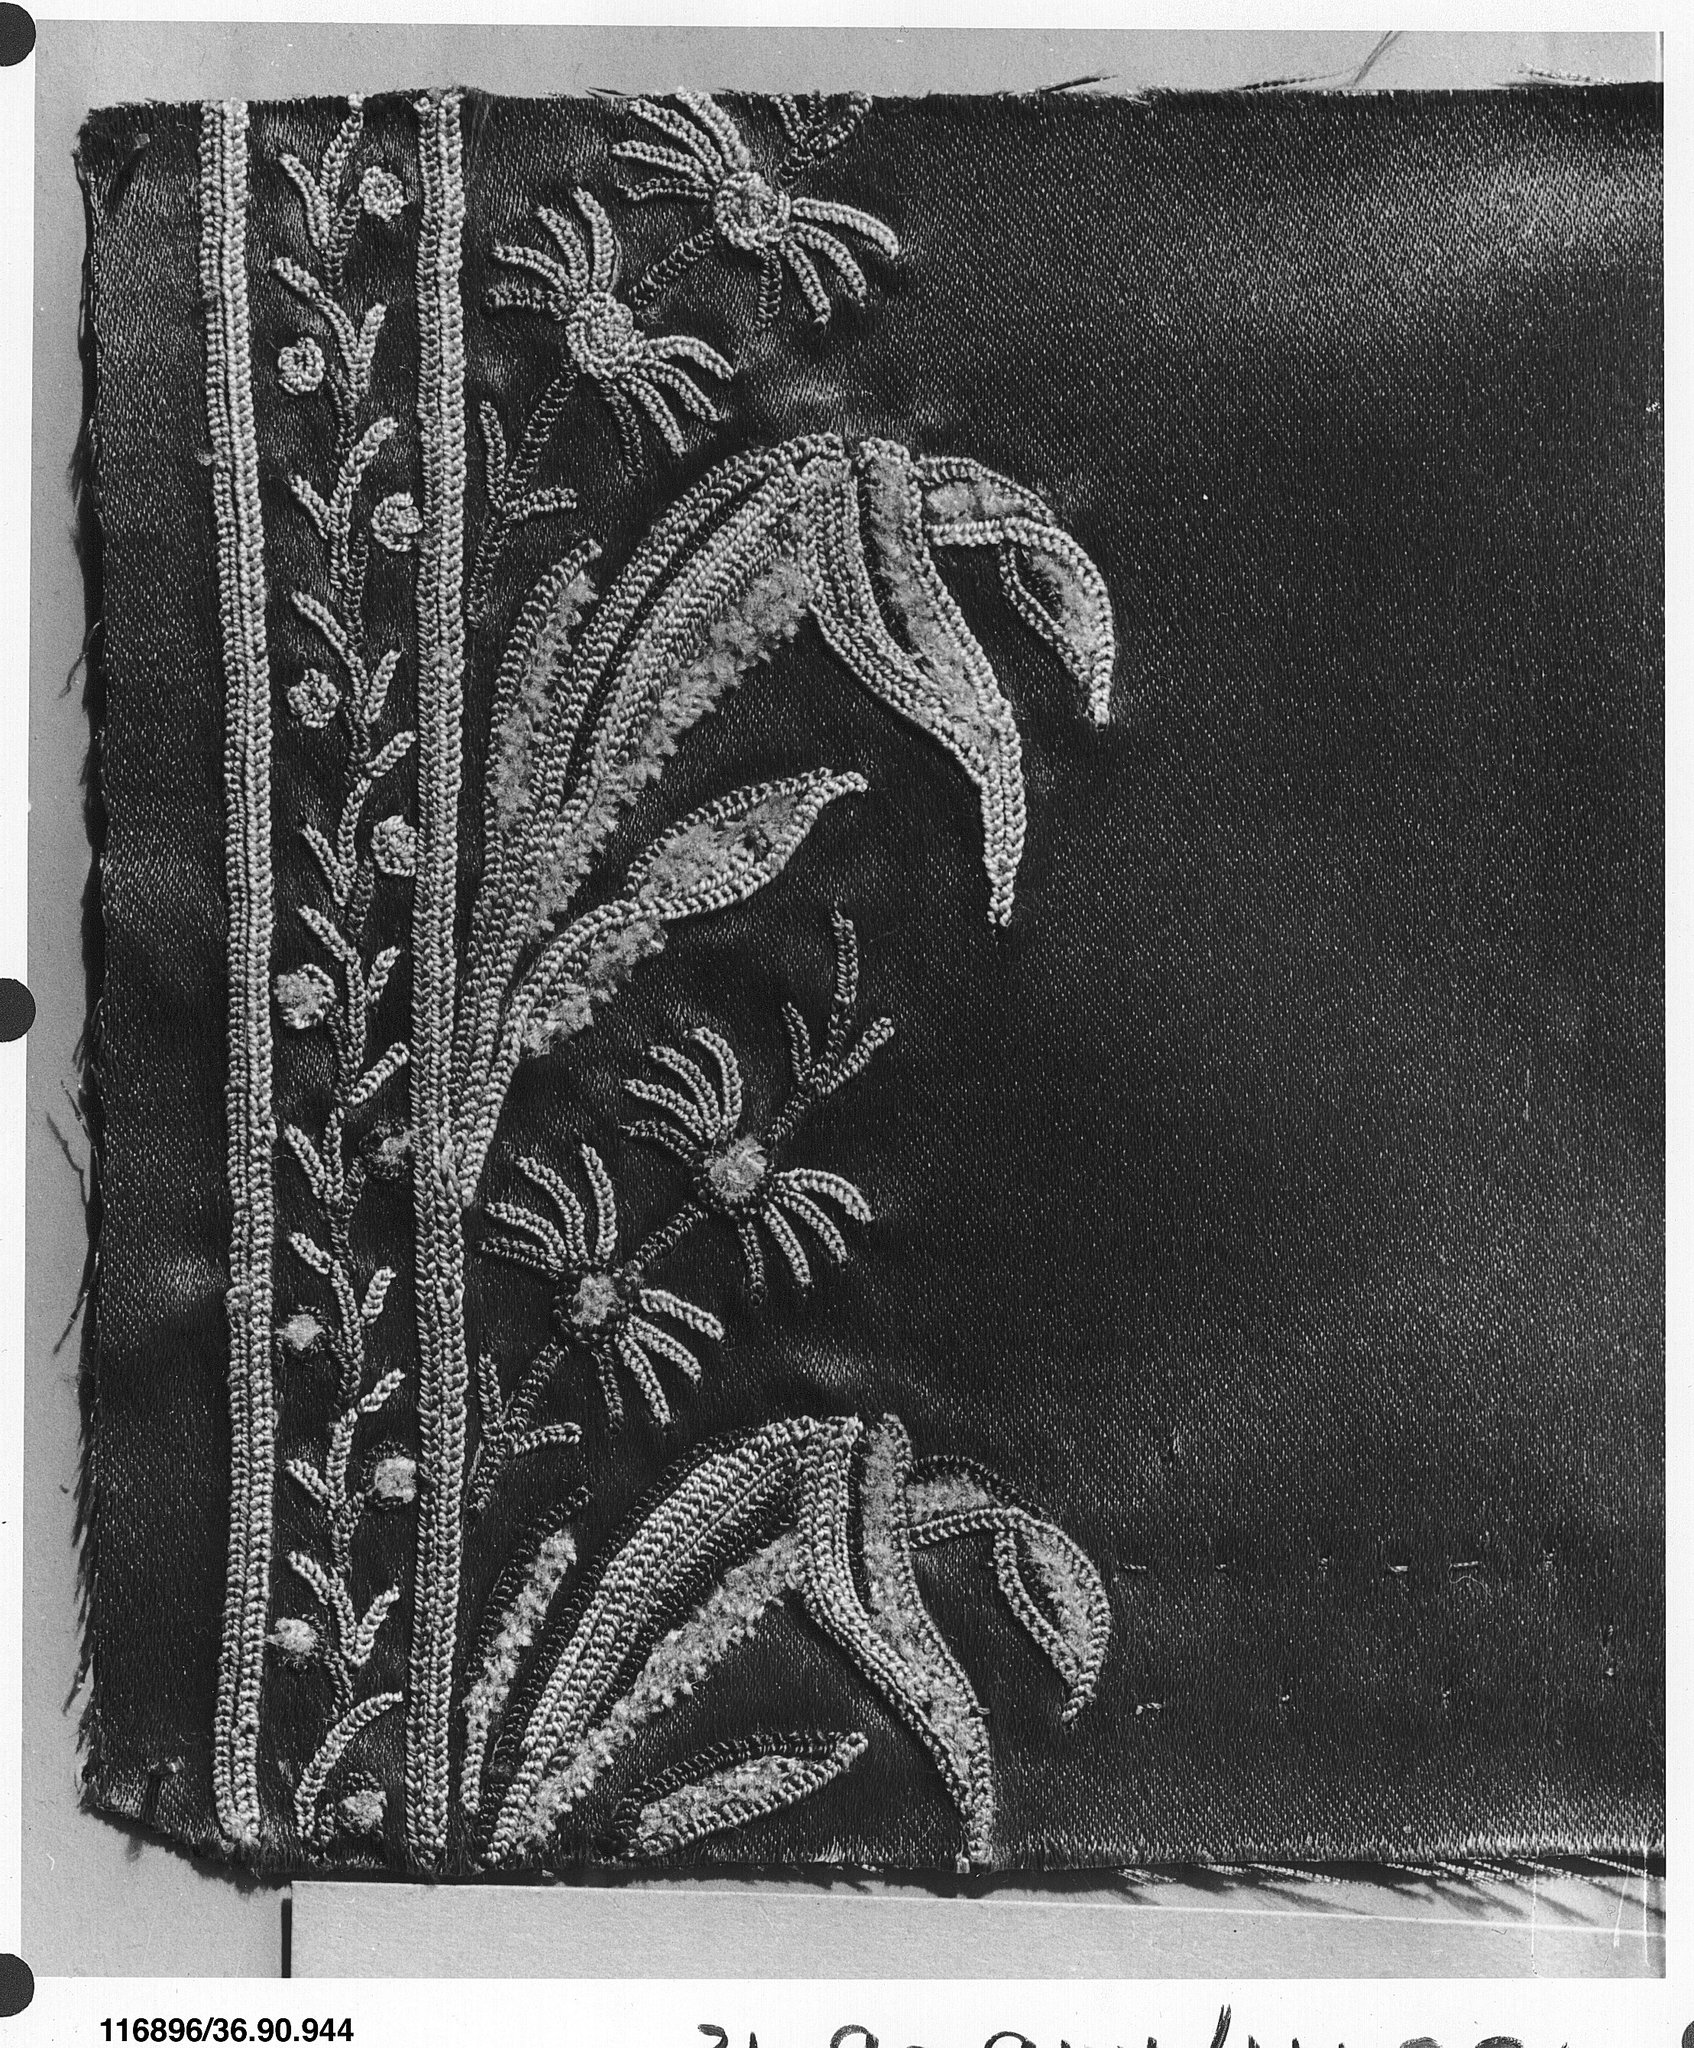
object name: sample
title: Embroidery sample for a man’s suit or waistcoat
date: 1785-1815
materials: silk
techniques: embroidery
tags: flowers